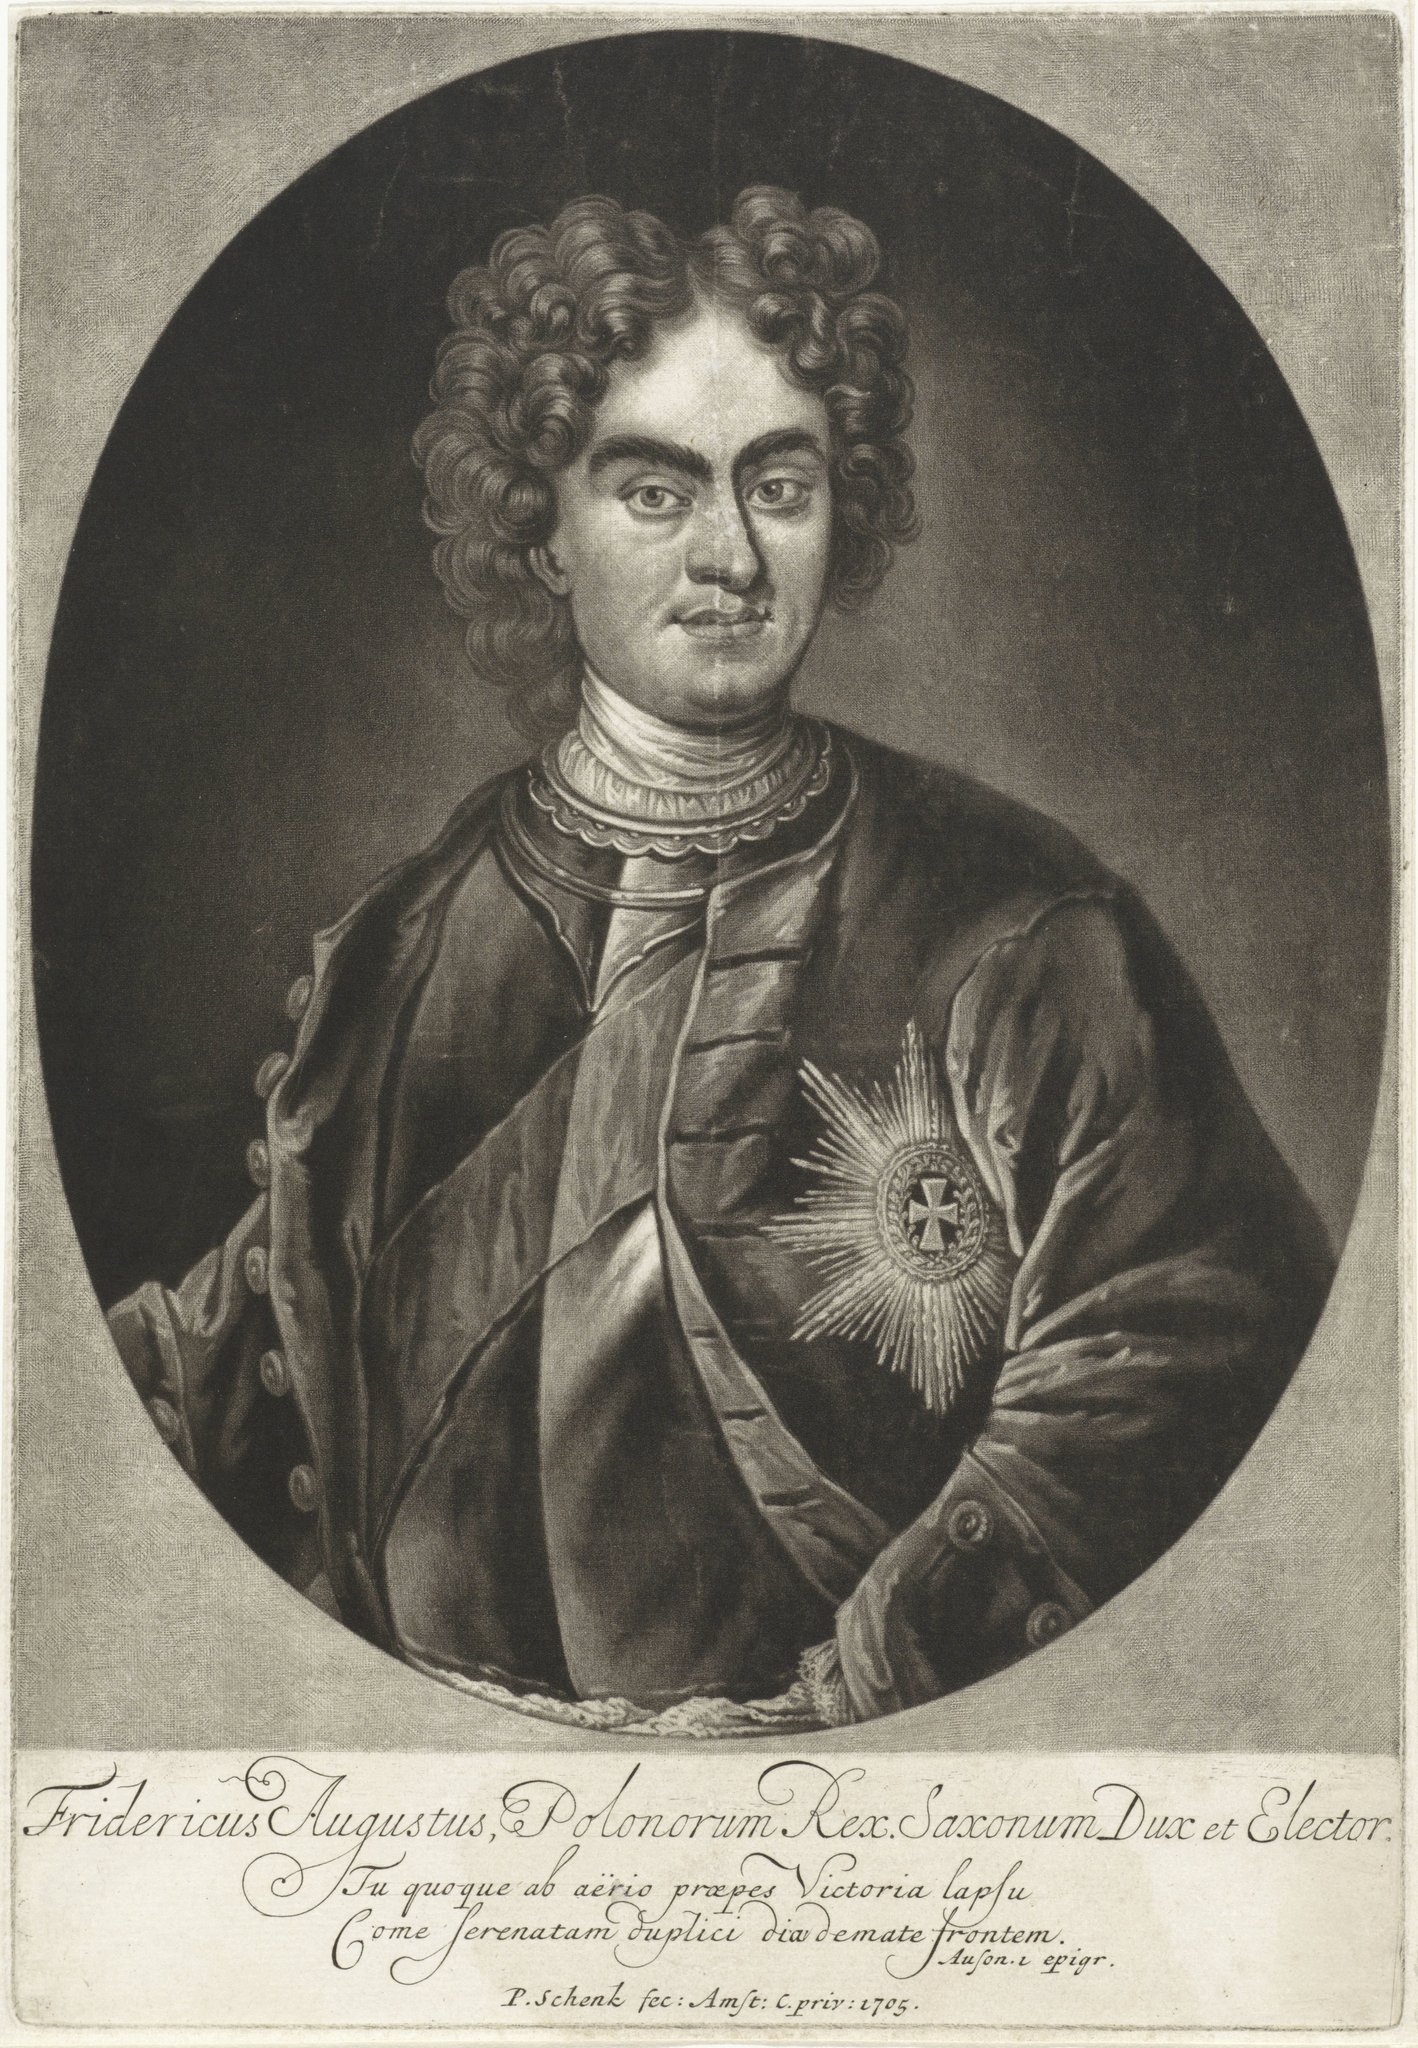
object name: print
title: Portret van Augustus II, koning van Polen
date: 1705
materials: paper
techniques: engraving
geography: amsterdam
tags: august ii (king of poland)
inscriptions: collector's mark: Lugt 2228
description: Augustus II, keurvorst van Saksen en koning van Polen, bijgenaamd 'De Sterke'. In Saksen werd hij Frederik August I genoemd.